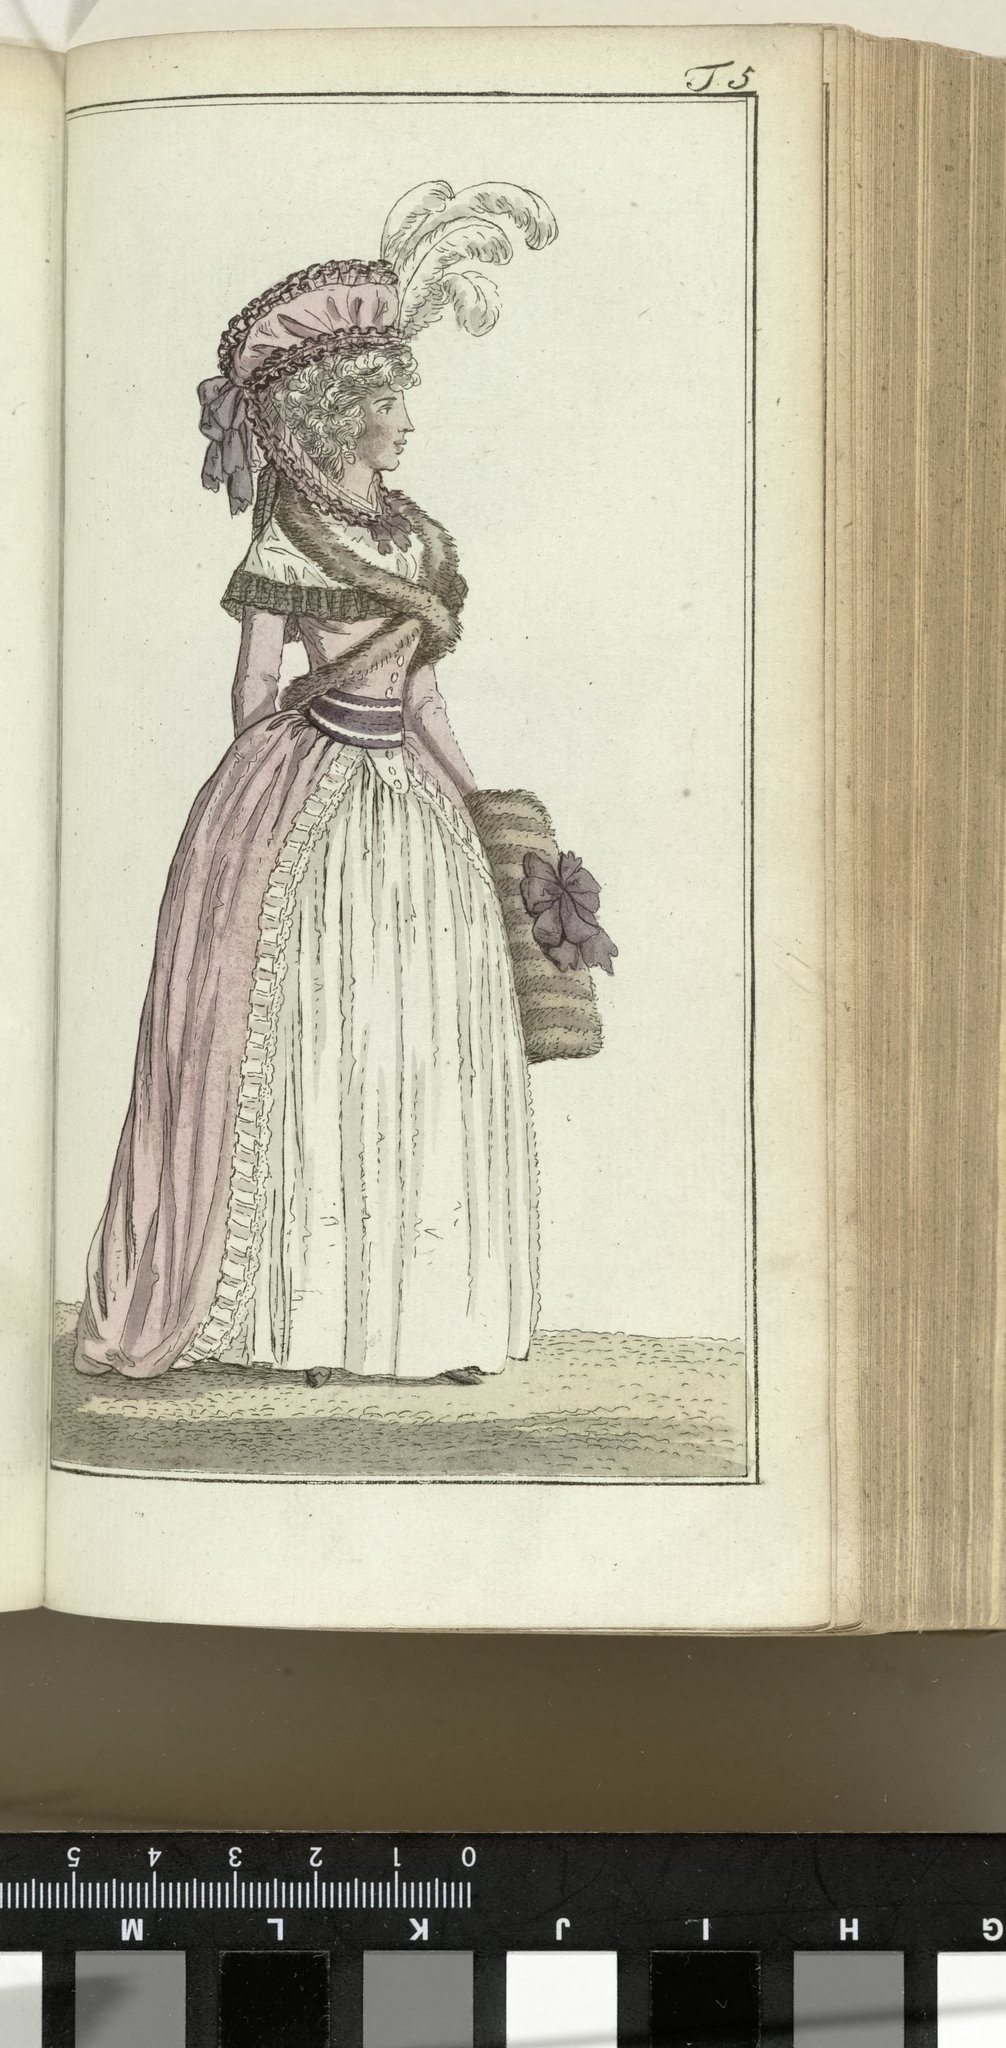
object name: magazine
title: Journal des Luxus und der Moden 1790, Band V, T.5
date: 1790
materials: paper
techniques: etching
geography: weimar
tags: fashion plates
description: Prent uit het modetijdschrift Journal des Luxus und der Moden, uitgegeven door Friedrich Justin Bertuch en Georg Melchior Kraus, Weimar, 1786-1826.